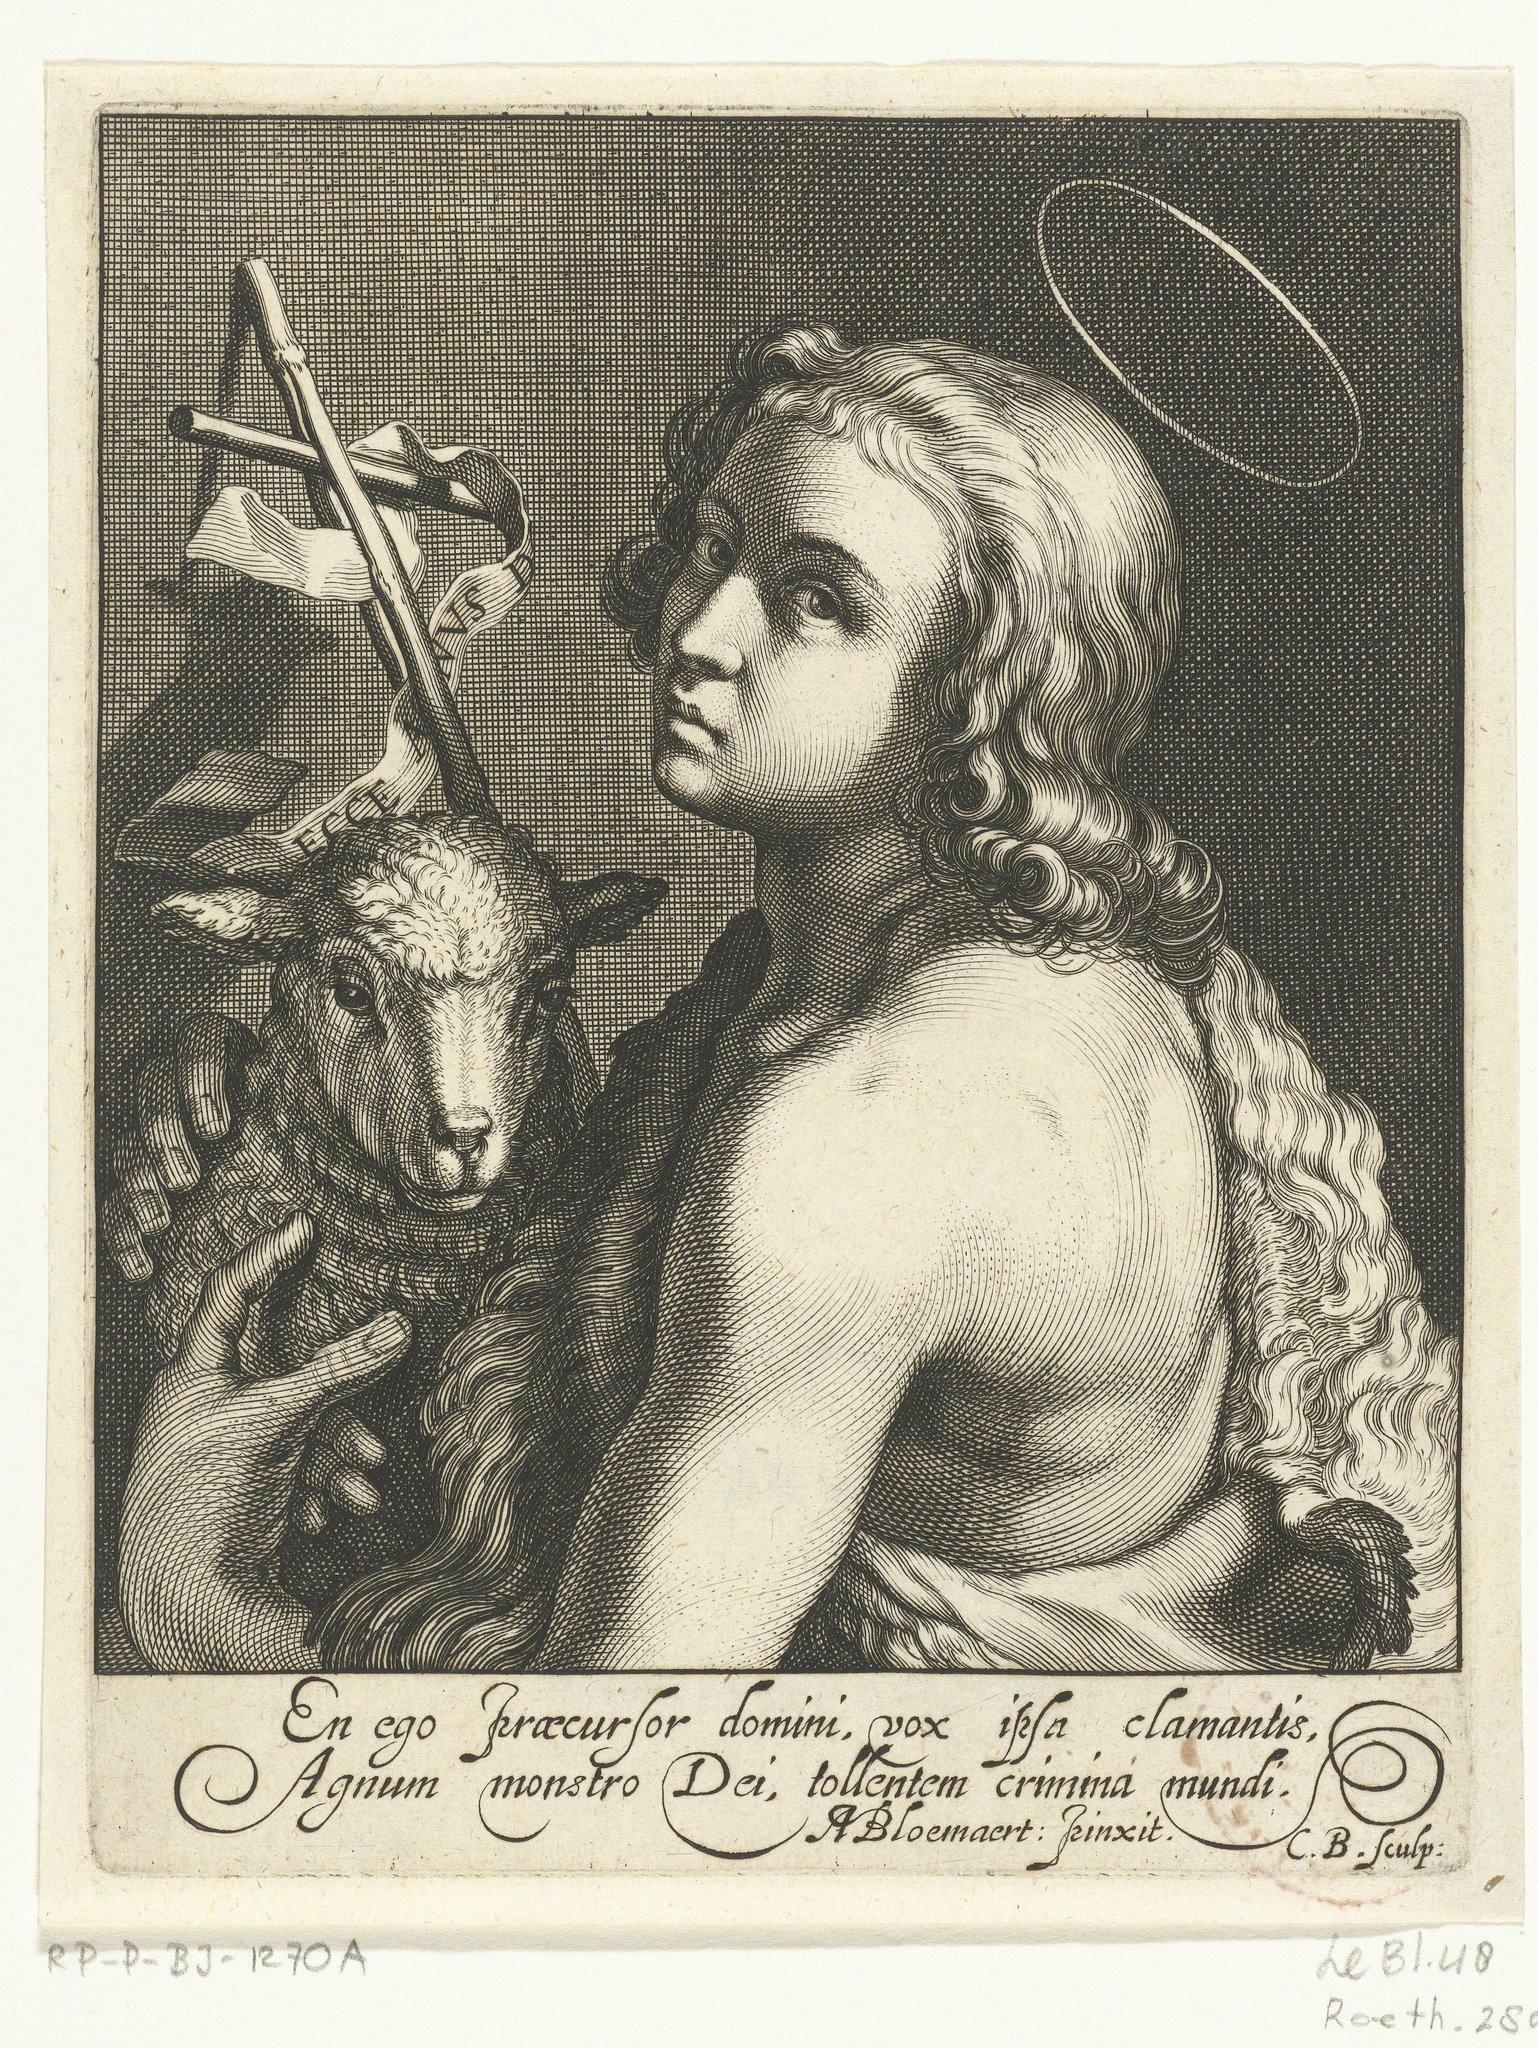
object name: print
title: Johannes de Doper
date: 1625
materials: paper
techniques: engraving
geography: utrecht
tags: john the baptist; possible attributes: book, reed cross, baptismal cup, honeycomb, lamb, staff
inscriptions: collector's mark: Lugt 240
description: Johannes de Doper, afgebeeld als een herdersjongen, naar links kijkend, houdt een lam vast en een kruis met de spreuk 'Ecce Agnus Dei'.